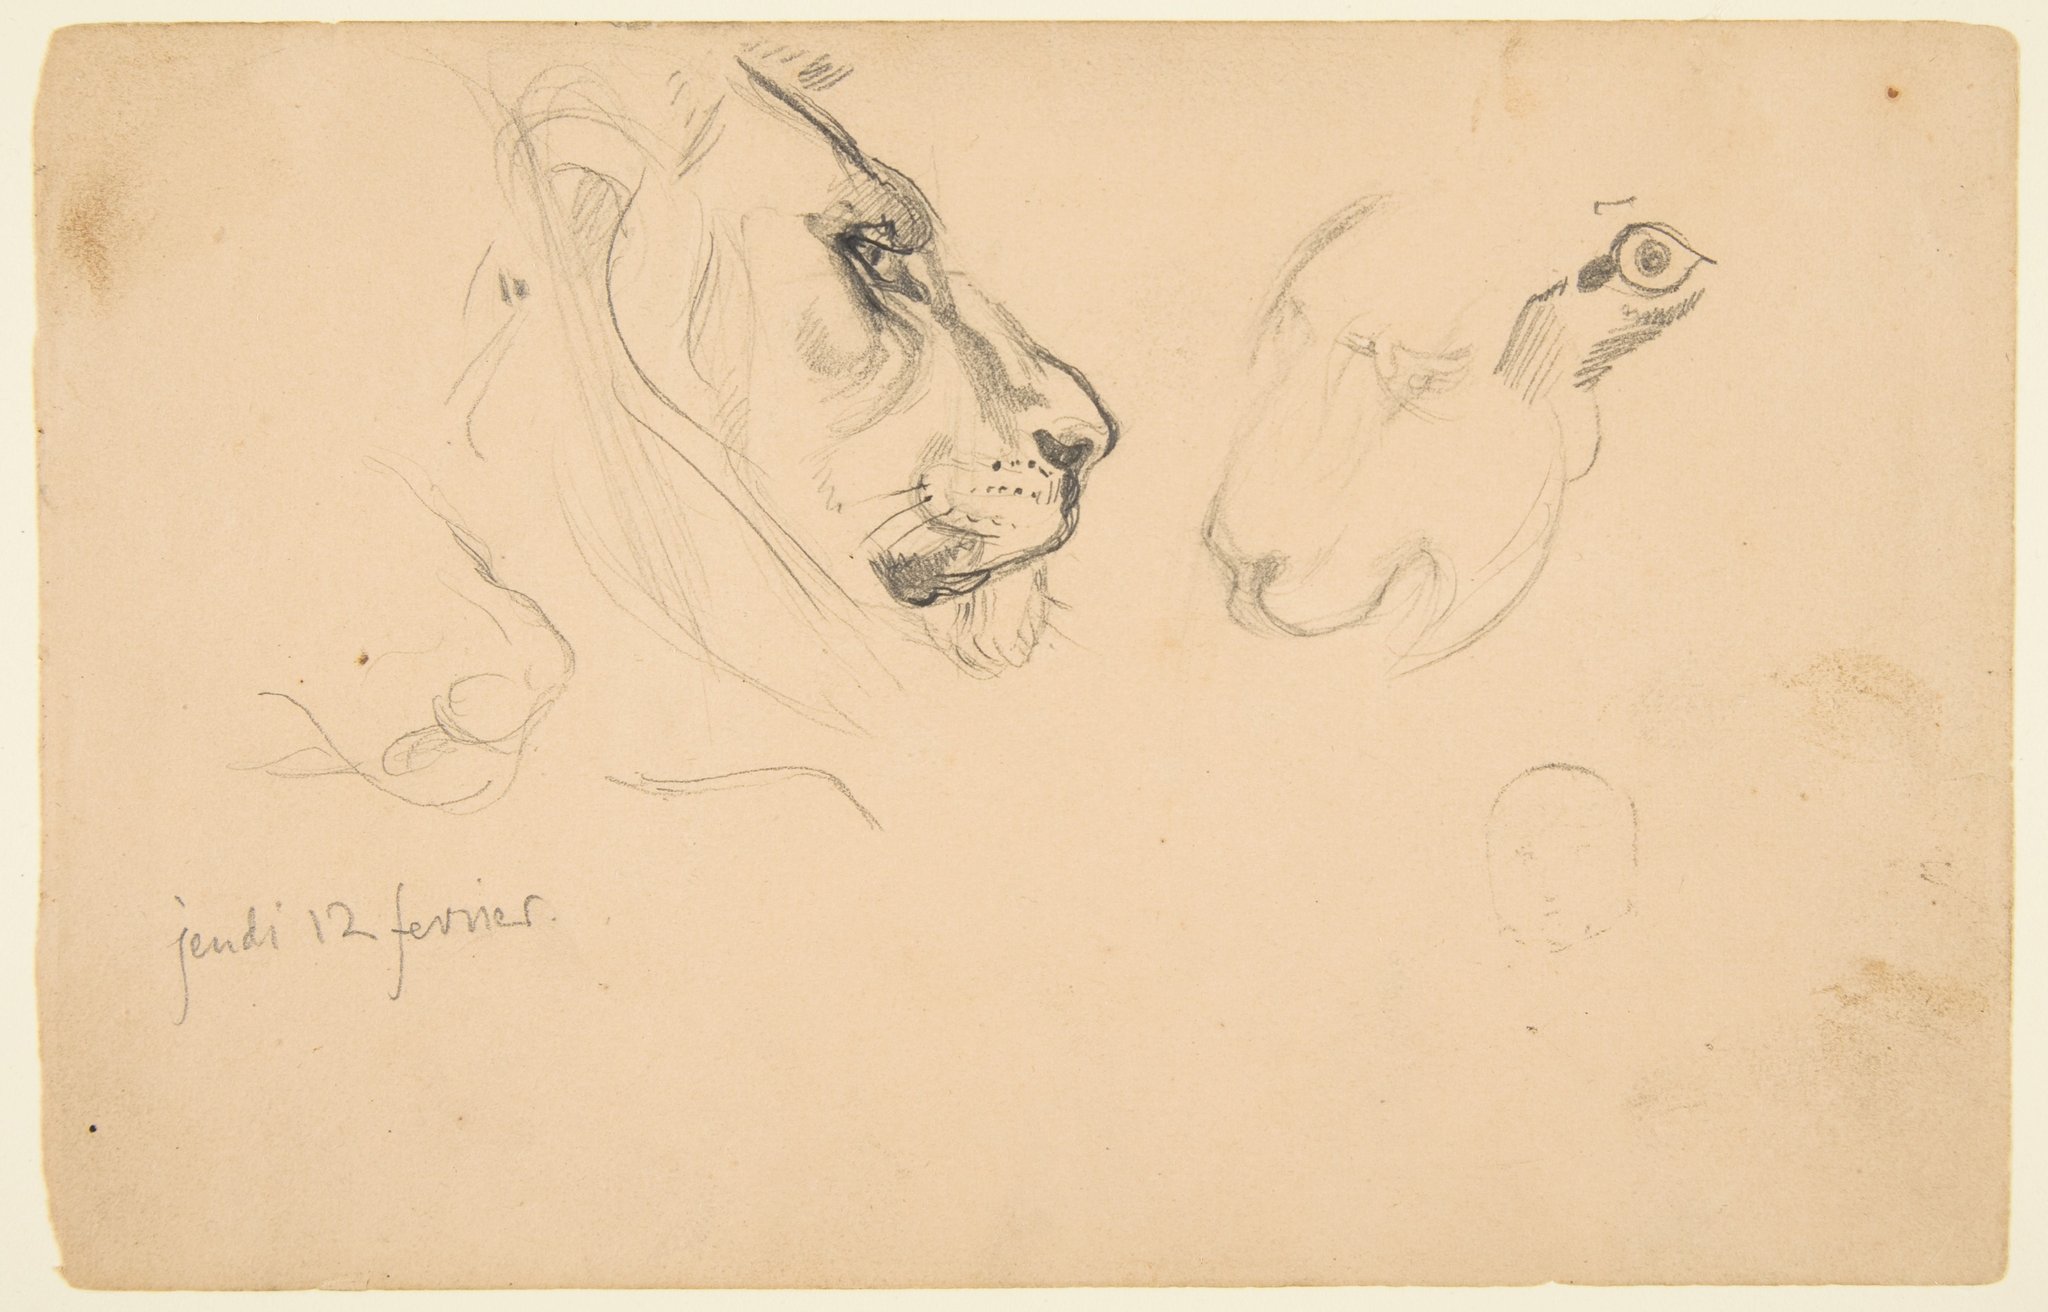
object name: drawing sketchbook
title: Sketchbook with views of Tours, France and its environs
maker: eugène delacroix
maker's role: artist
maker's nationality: french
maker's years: 1798-1863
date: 1828-1829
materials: graphite, watercolor, paper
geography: france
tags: lions